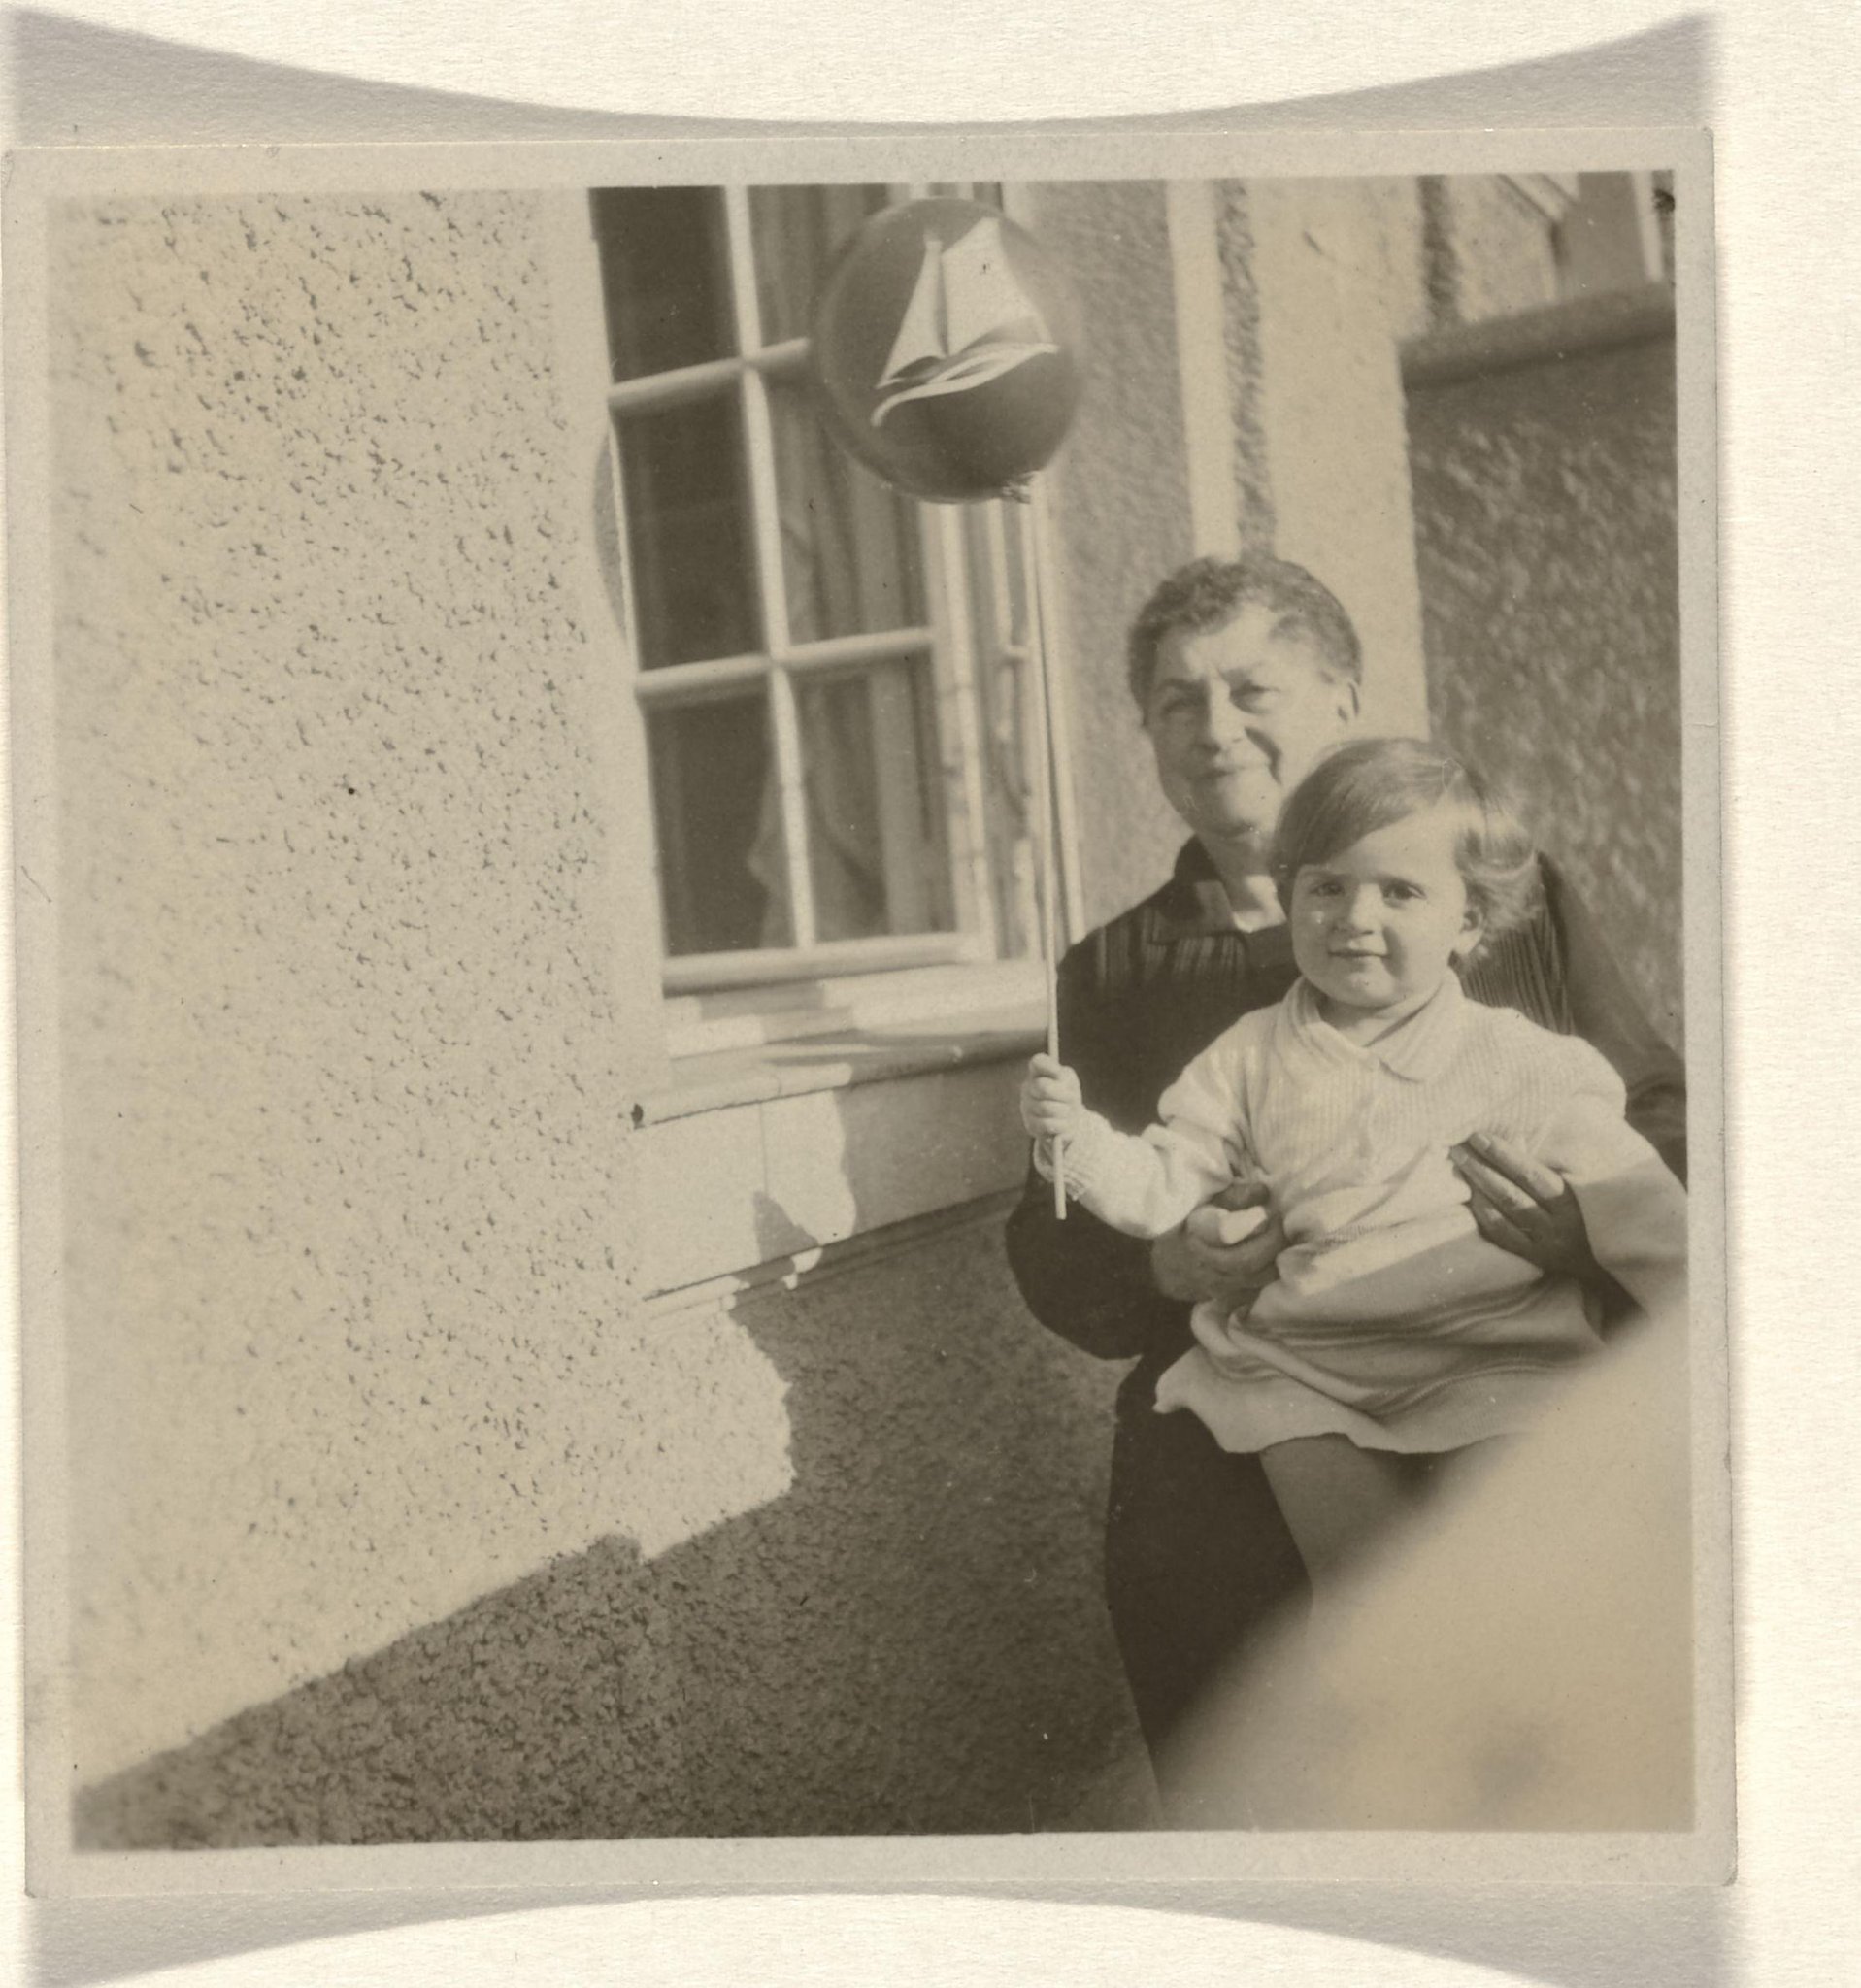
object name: photograph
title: Isabel Wachenheimer op schoot bij haar grootmoeder Josefine Levi-Moos, op het balkon bij de woning van de familie Wachenheimer, januari 1930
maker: Anonymous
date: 1901-1930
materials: photographic support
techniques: gelatin silver print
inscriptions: number: ‘5’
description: Dit object is onderdeel van de nalatenschap van Isabel Elon-Wachenheimer (1928-2010). Tot haar overlijden behoorde het samen met de andere objecten uit de nalatenschap tot haar privédomein van Isabel Wachenheimer. In die particuliere context zijn deze objecten tezamen en individueel aandenkens - aan de jeugd, ouders en familie van Isabel Wachenheimer vóór en tijdens de Shoah en aan haar leven na de Tweede Wereldoorlog. Isabel Wachenheimer, die van juni 1943 tot mei 1945 gevangen zat in Kamp Westerbork, Theresienstadt, Auschwitz, Lenzing a/d Oberdonau (een buitenkamp van Mauthausen), overleefde de Shoah. Haar ouders – Eugène Wachenheimer en Else Wachenheimer-Moos - werden op 14 oktober 1944 in Auschwitz-Birkenau vermoord.